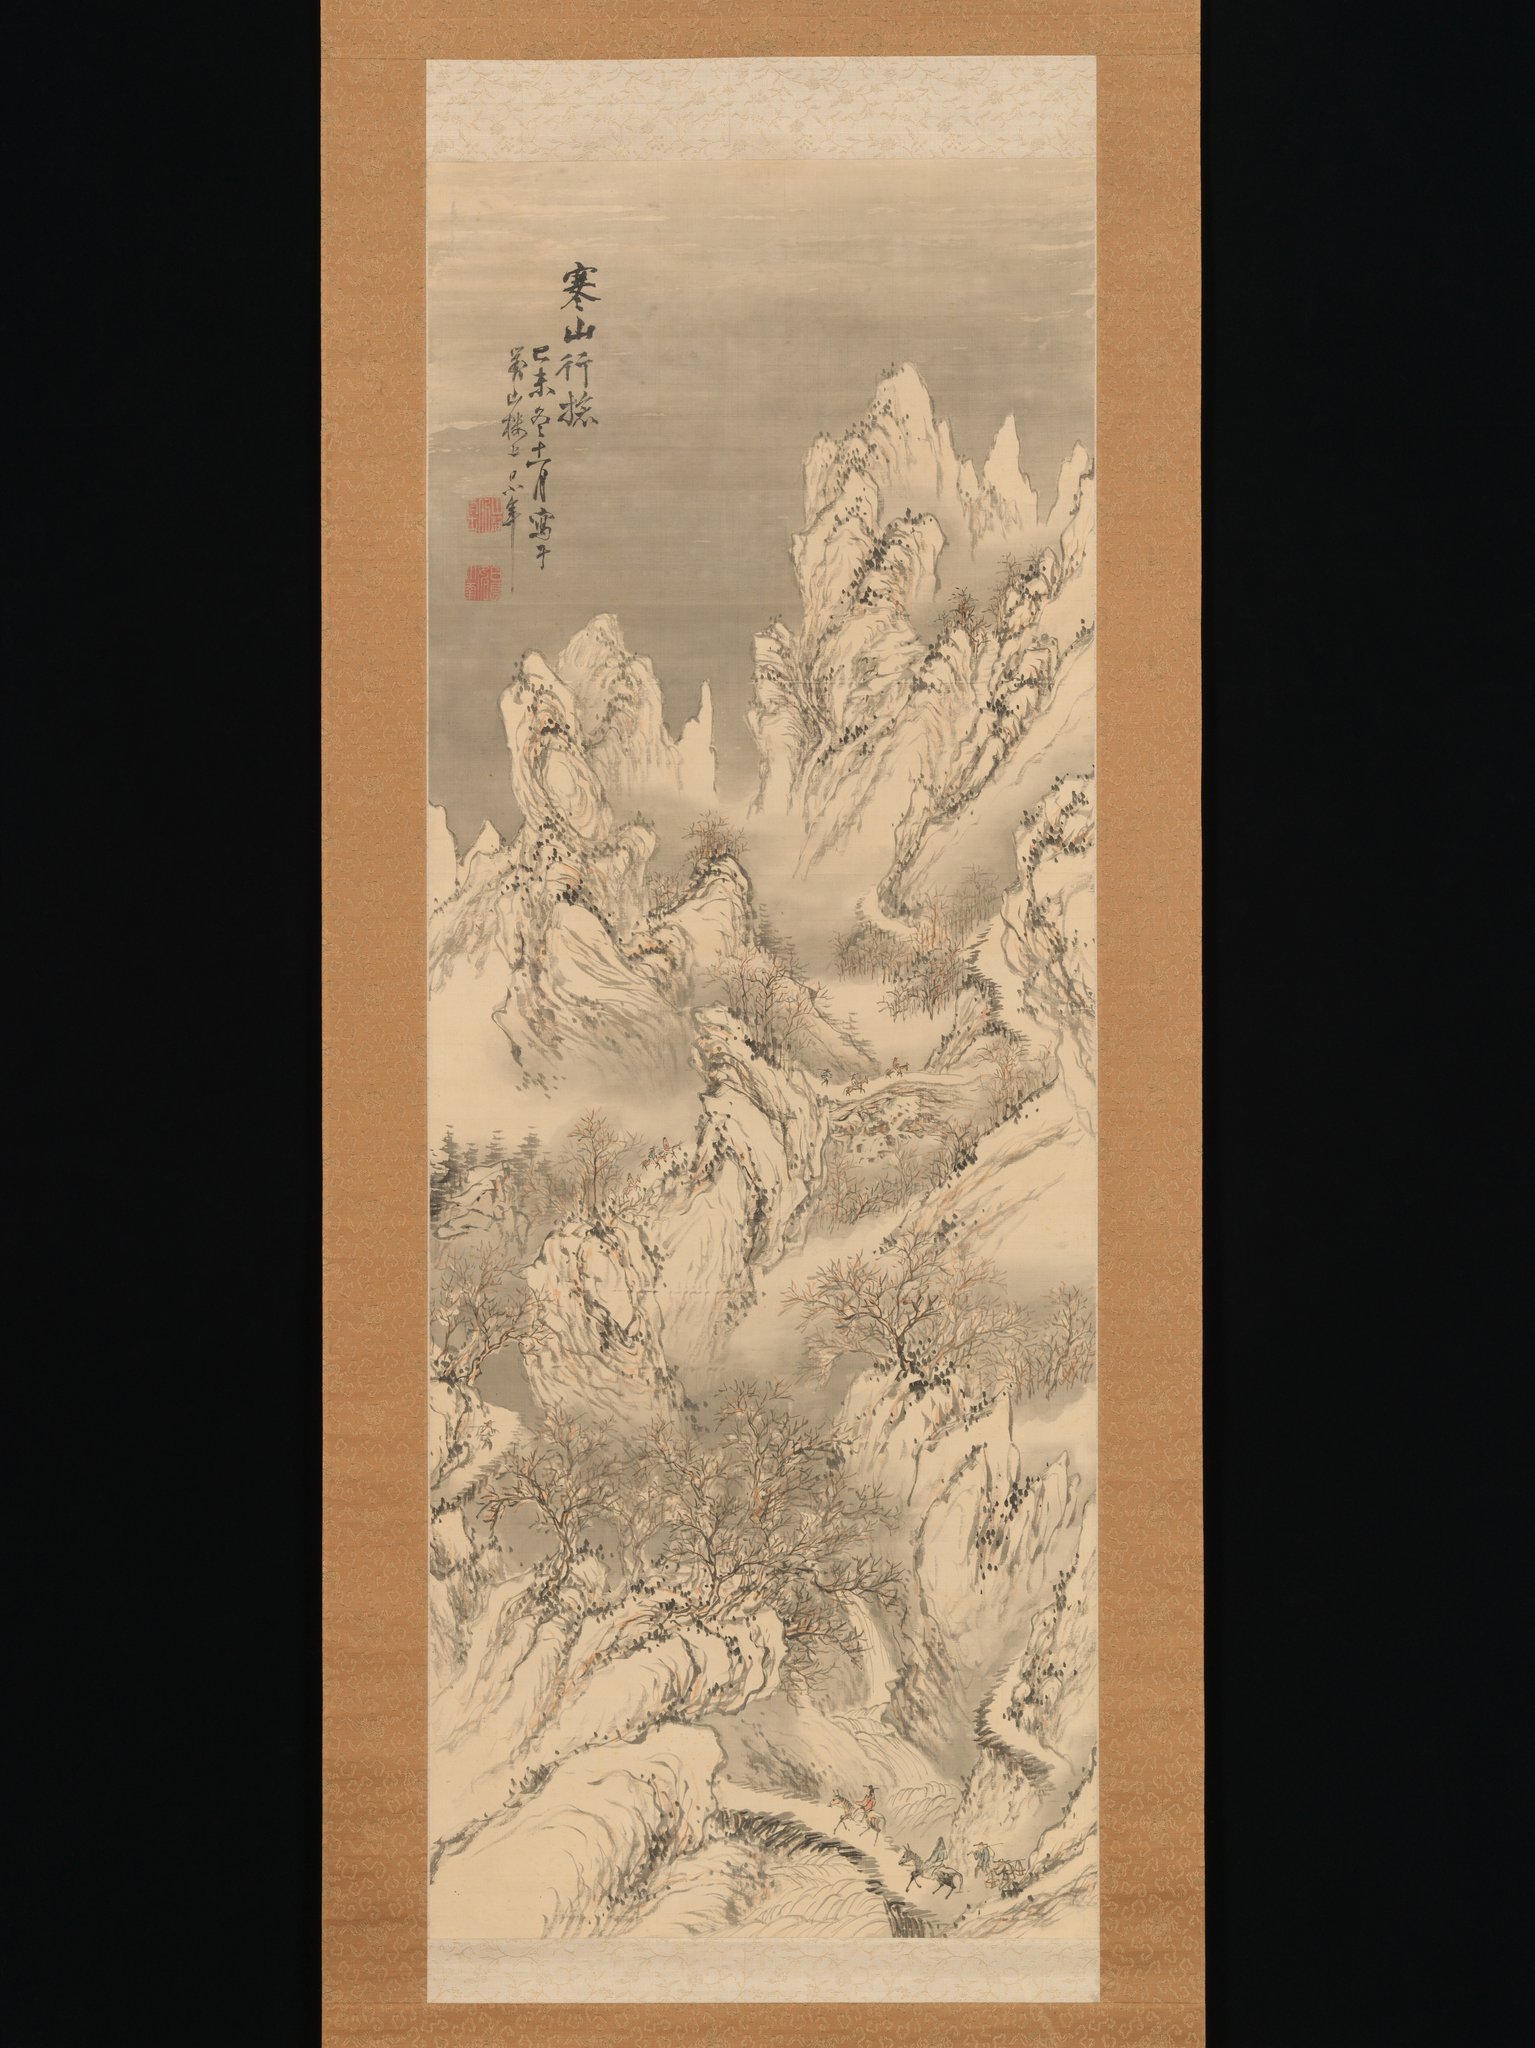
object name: hanging scroll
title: Travellers in Cold Mountains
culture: japanese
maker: hine taizan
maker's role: artist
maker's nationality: japanese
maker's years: 1813-1869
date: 1859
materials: ink, silk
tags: mountains,landscapes